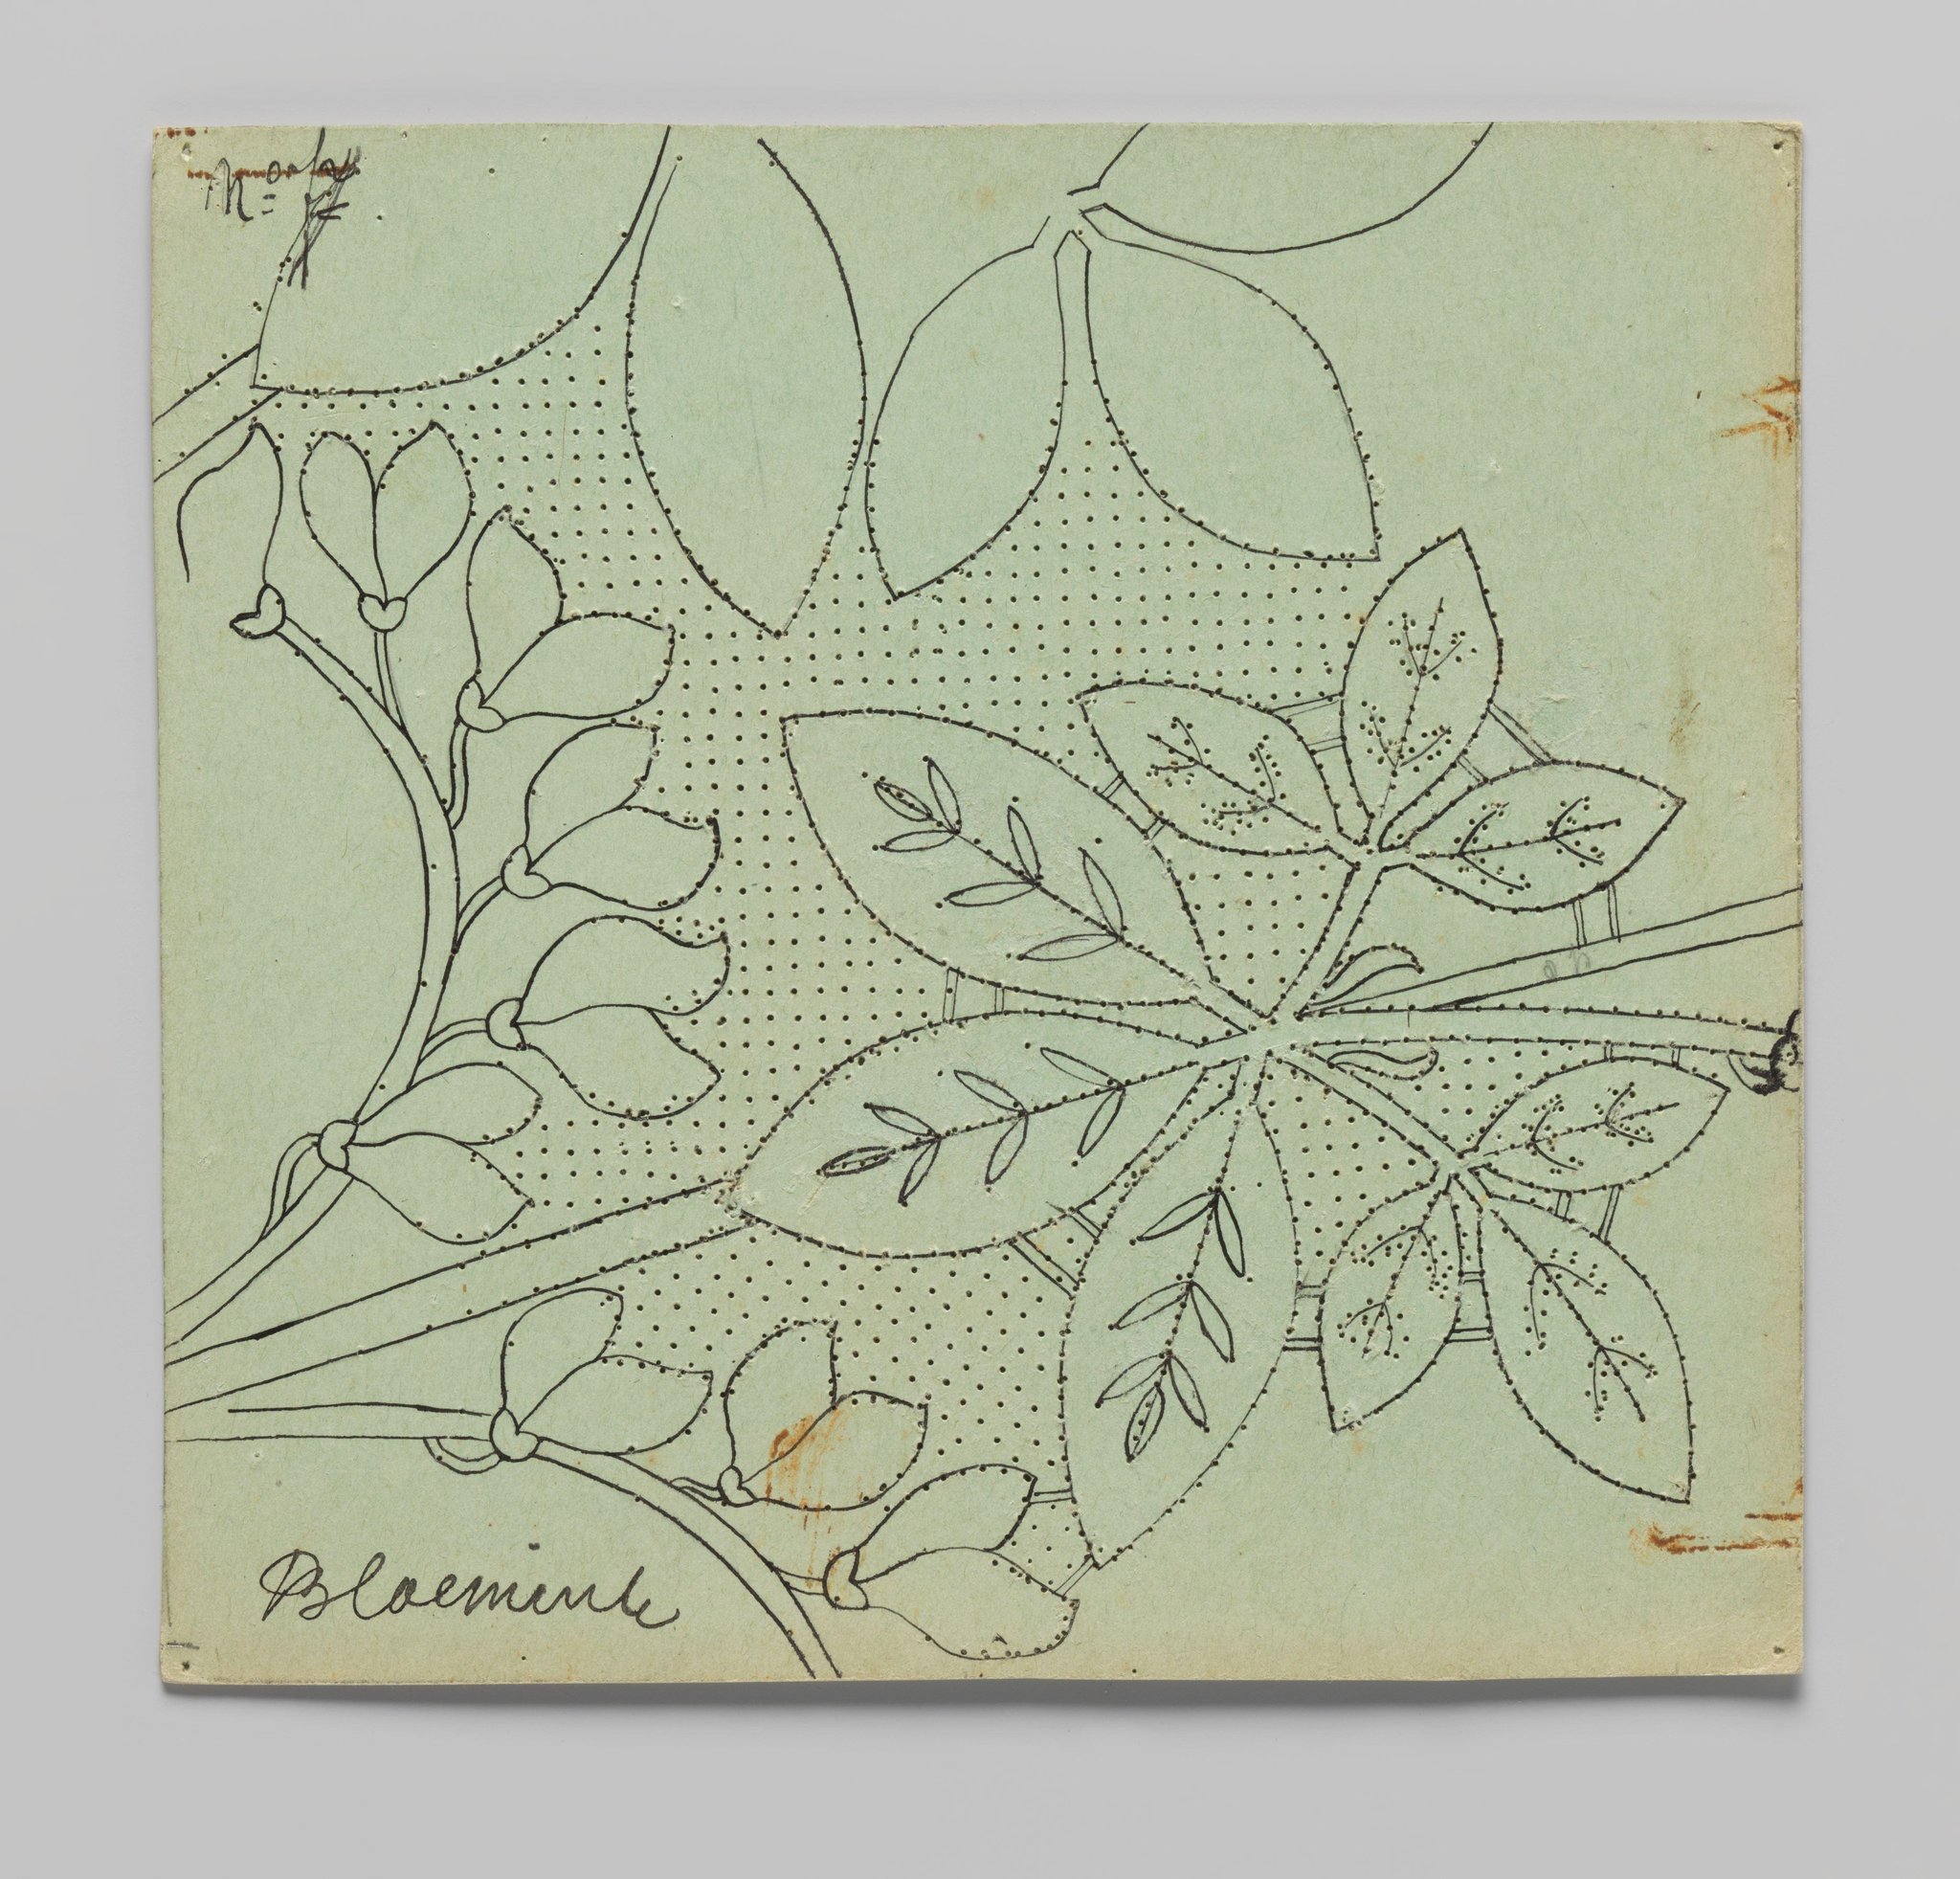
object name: tool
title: Kantpatroon voor een kleed van kloskant met goudenregentakken en -bloemen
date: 1912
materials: paper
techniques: drawing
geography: apeldoorn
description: Kantbrief of kantpatroon met een deel van het patroon voor een kleed met invnr. BK-1979-84. De brief is genummerd (7) en op de voorkant is de naam Bloemink geschreven.